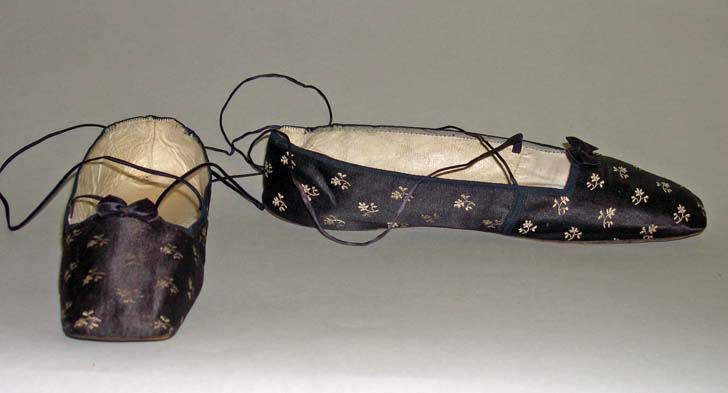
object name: slipper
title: Slippers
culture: british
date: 1830-1849